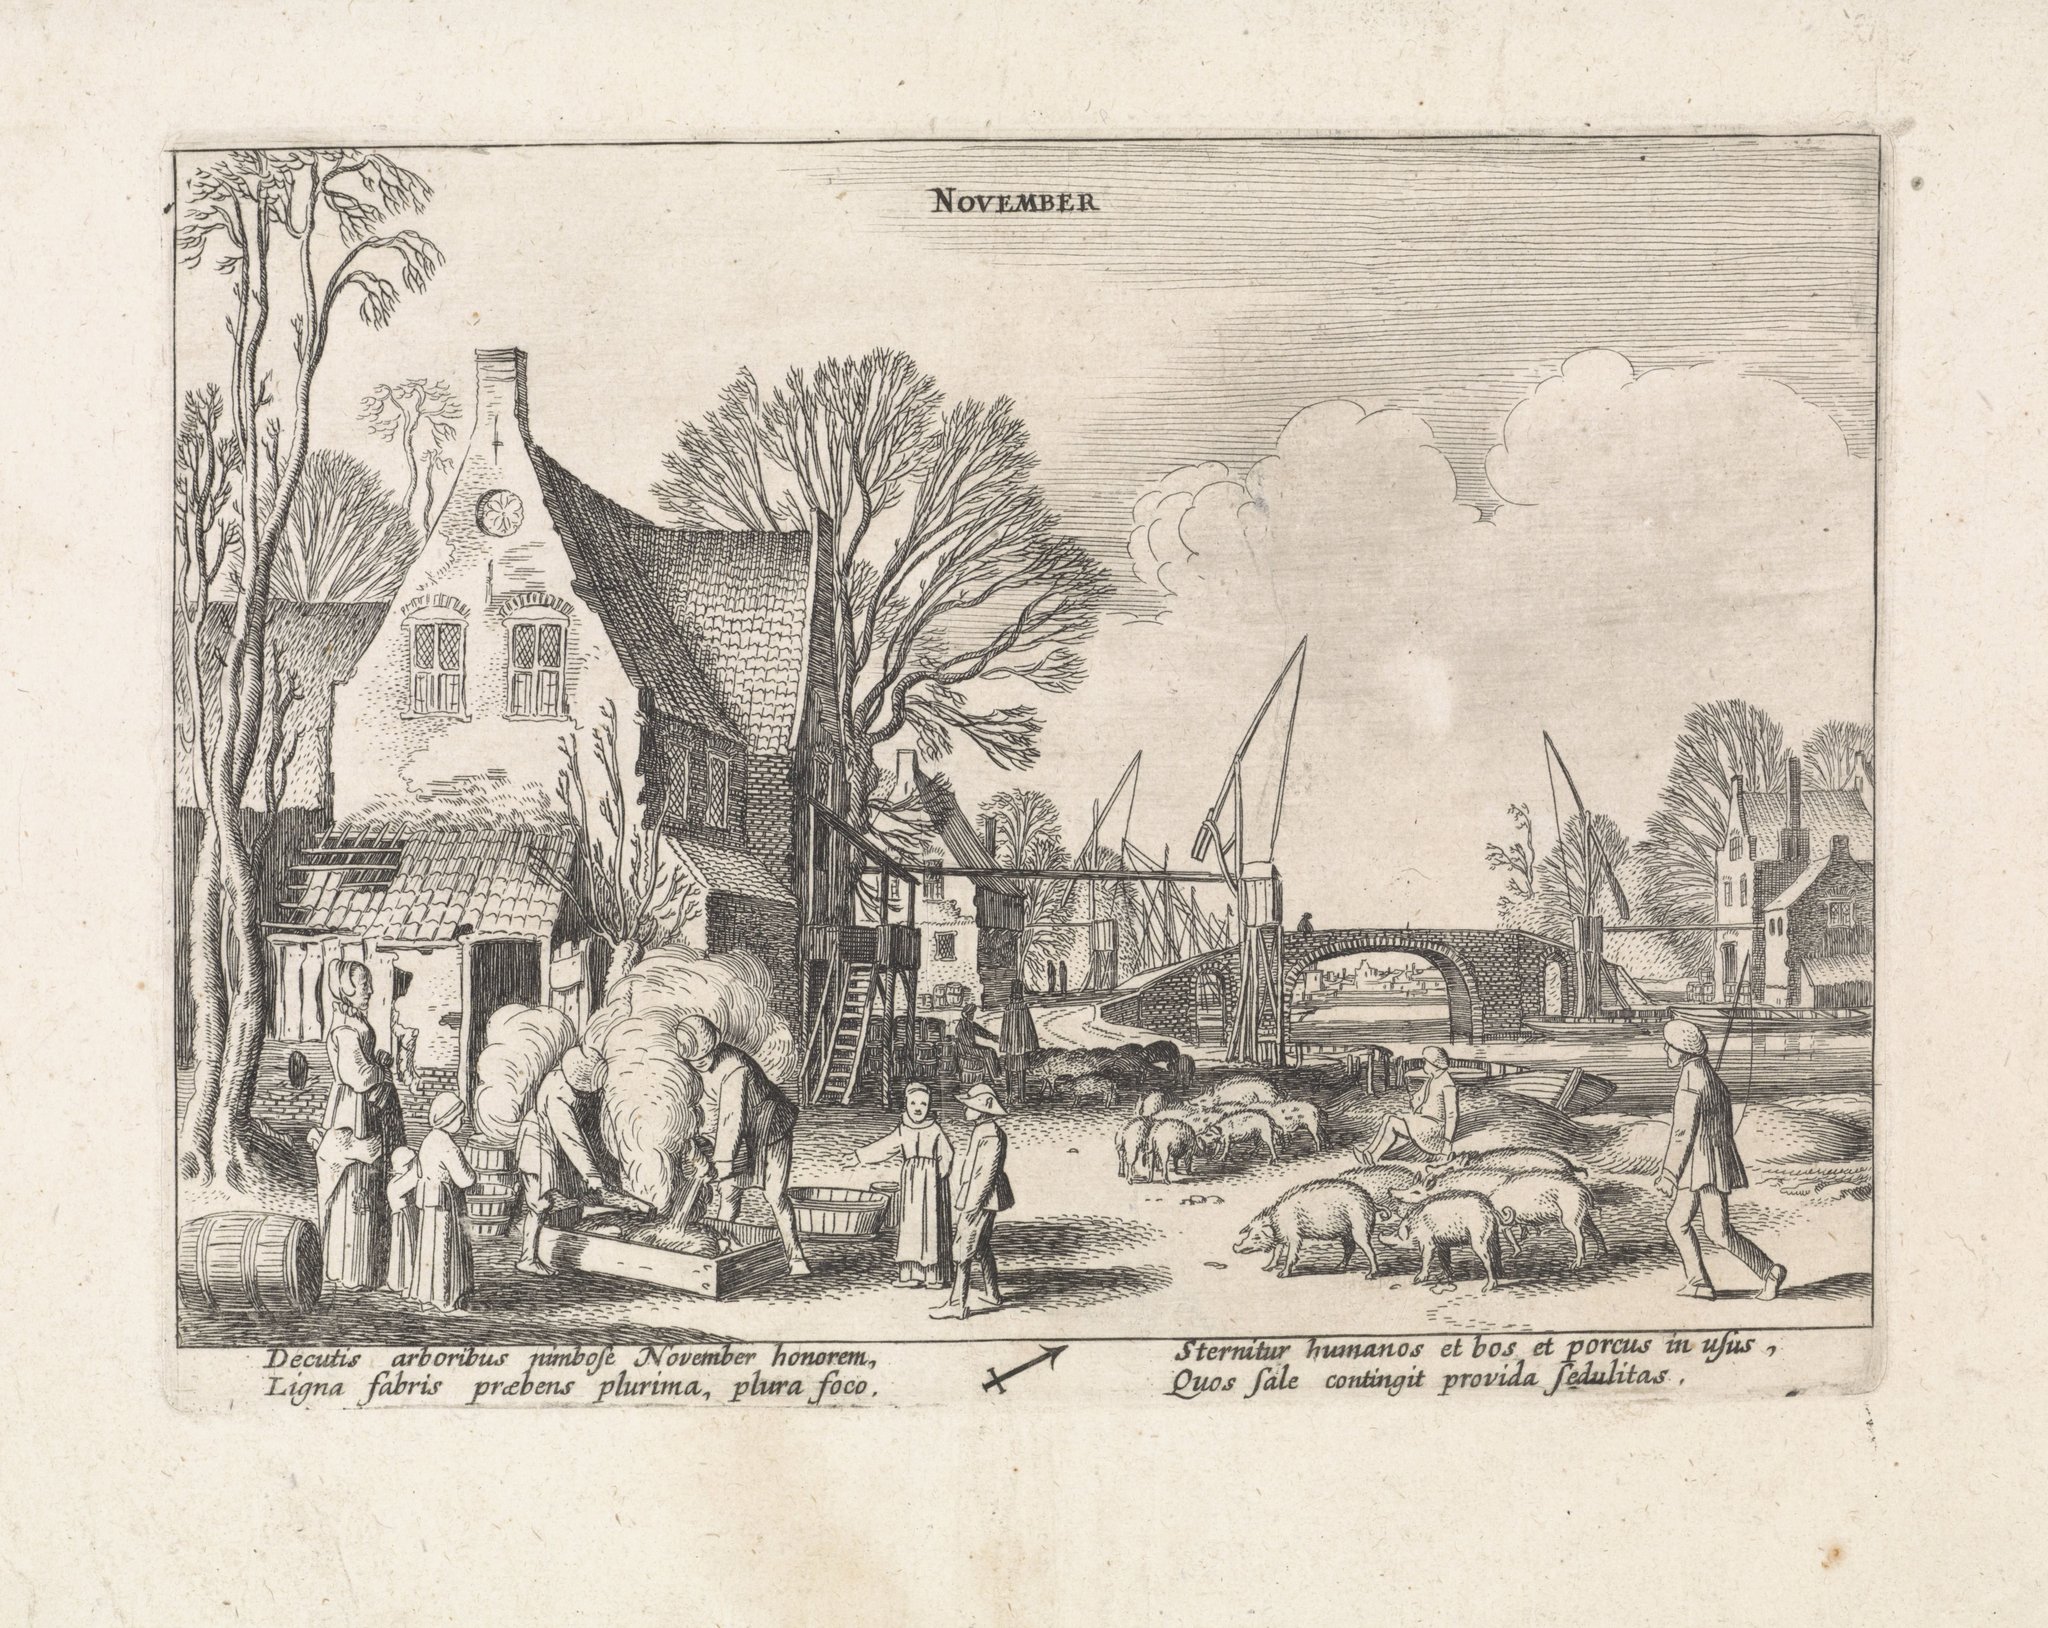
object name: print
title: De twaalf maanden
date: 1608-1618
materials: paper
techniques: etching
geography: northern netherlands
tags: landscape symbolizing november, pig, landscape with bridge, viaduct or aqueduct, sagittarius (zodiacal sign of november), village, slaughtered ox or pig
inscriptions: collector's mark: Lugt 964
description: Een dorpsgezicht met varkenshoeders en links twee figuren die een dood varken wassen, voorstellende de maand november. In het midden een stenen brug. Onderaan het astrologische symbool van het sterrenbeeld boogschutter. Prent uit een serie van twaalf.